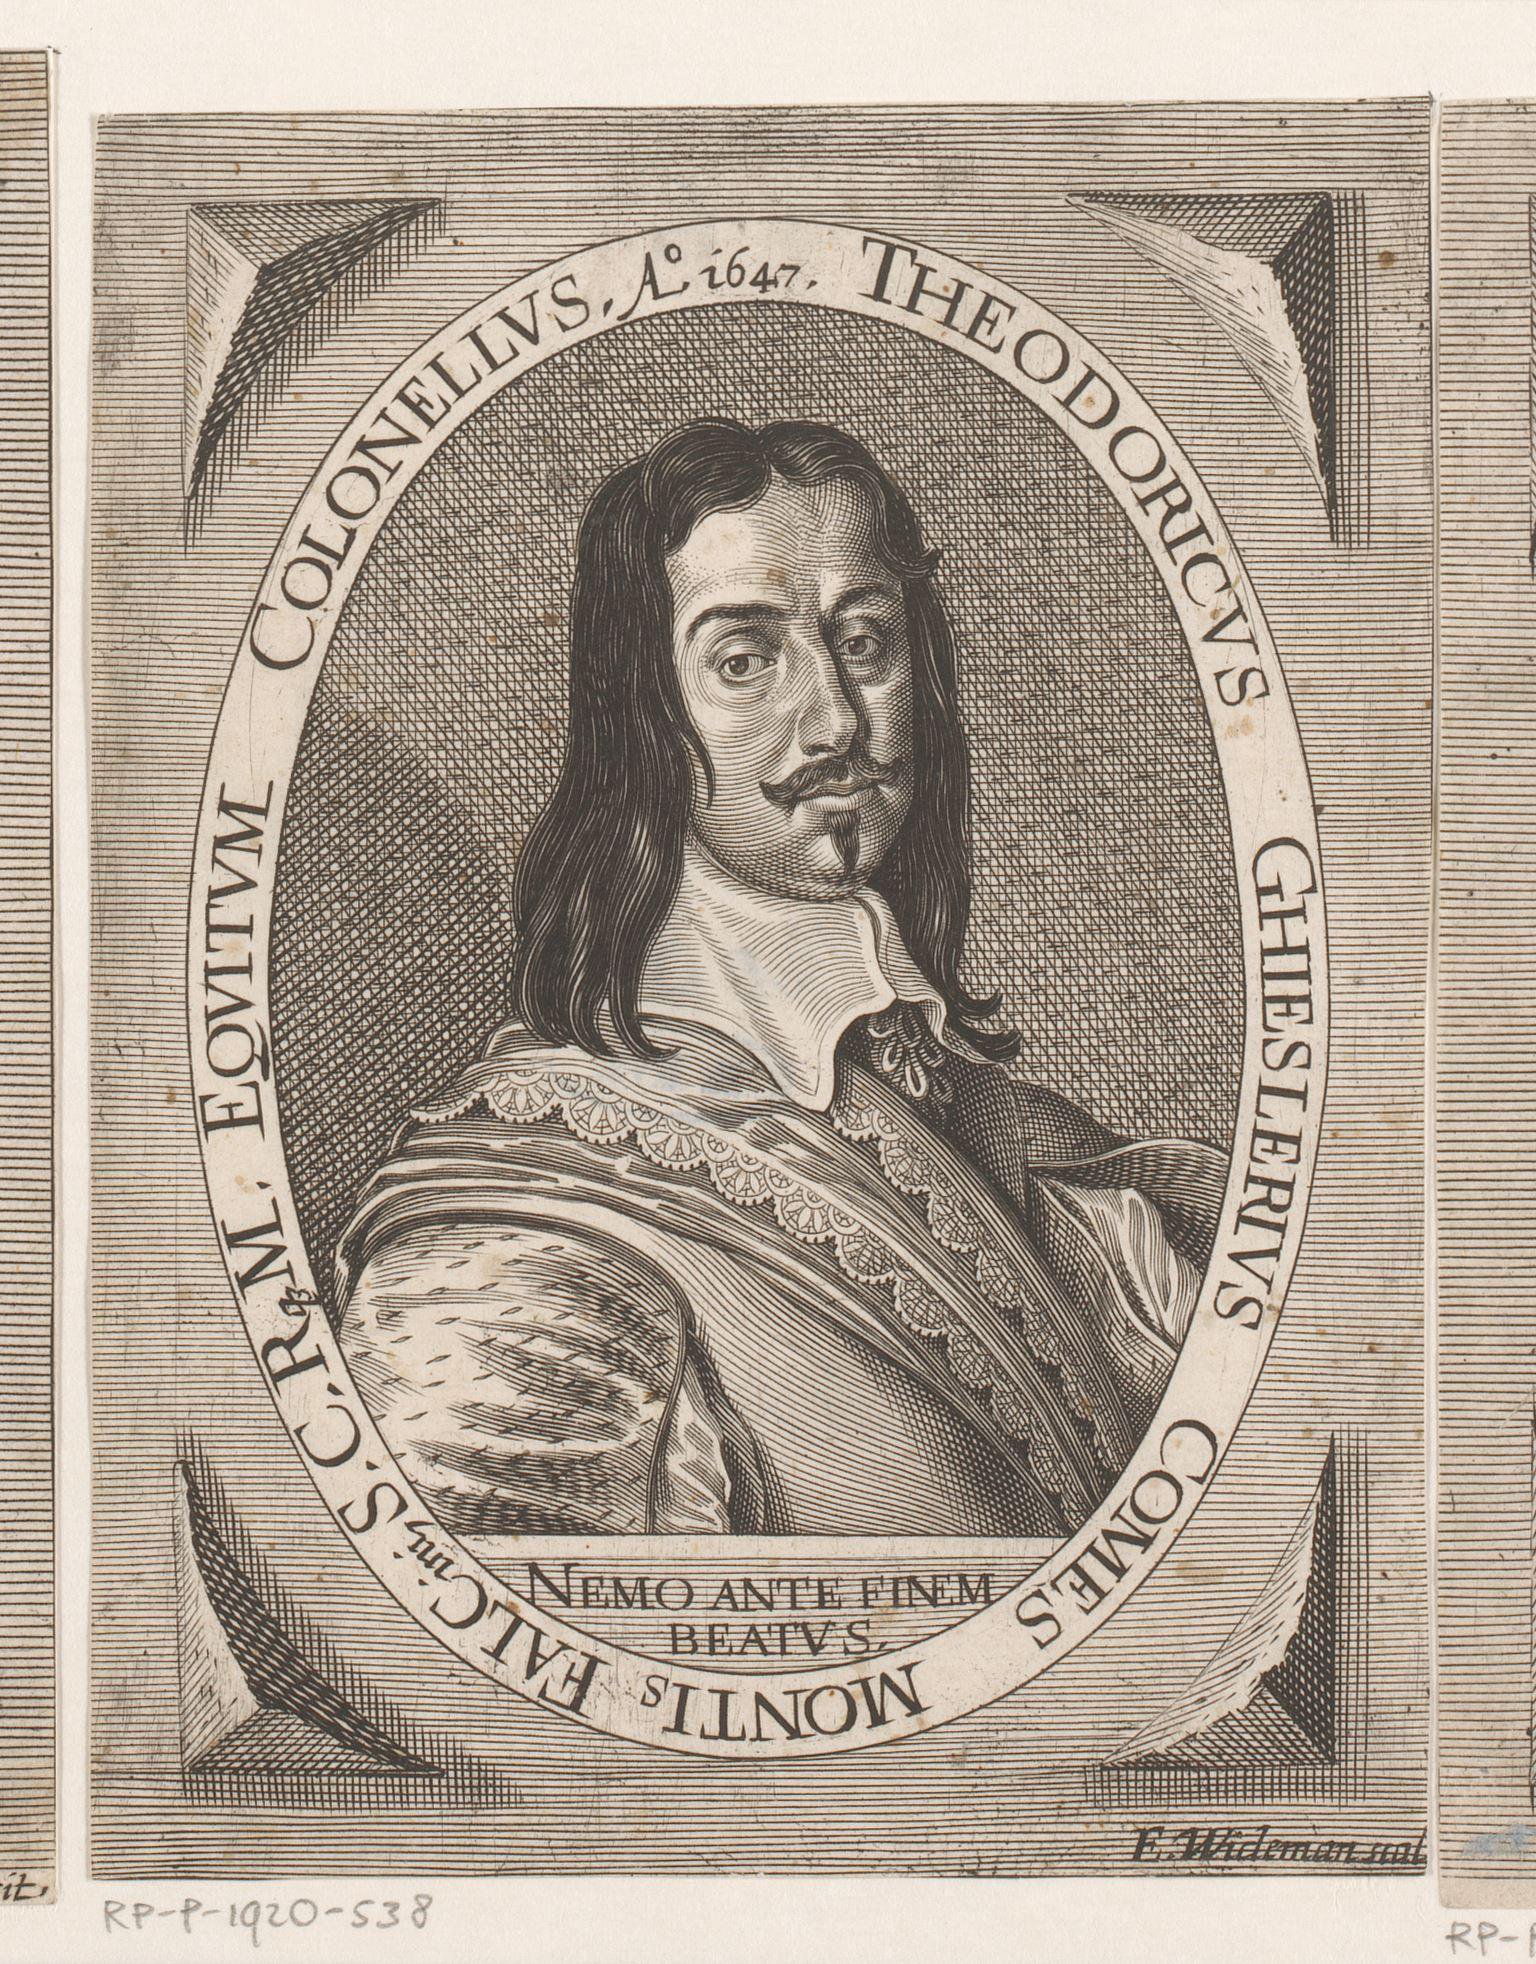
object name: print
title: Portret van Theodor Ghiesler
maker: elias widemann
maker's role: print maker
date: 1647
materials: paper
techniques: engraving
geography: vienna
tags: historical persons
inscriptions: collector's mark: Lugt 2228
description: Prent uit de publicatie: Widemann, Elias. Honori Sacrum. Wenen: s.n., 1649.